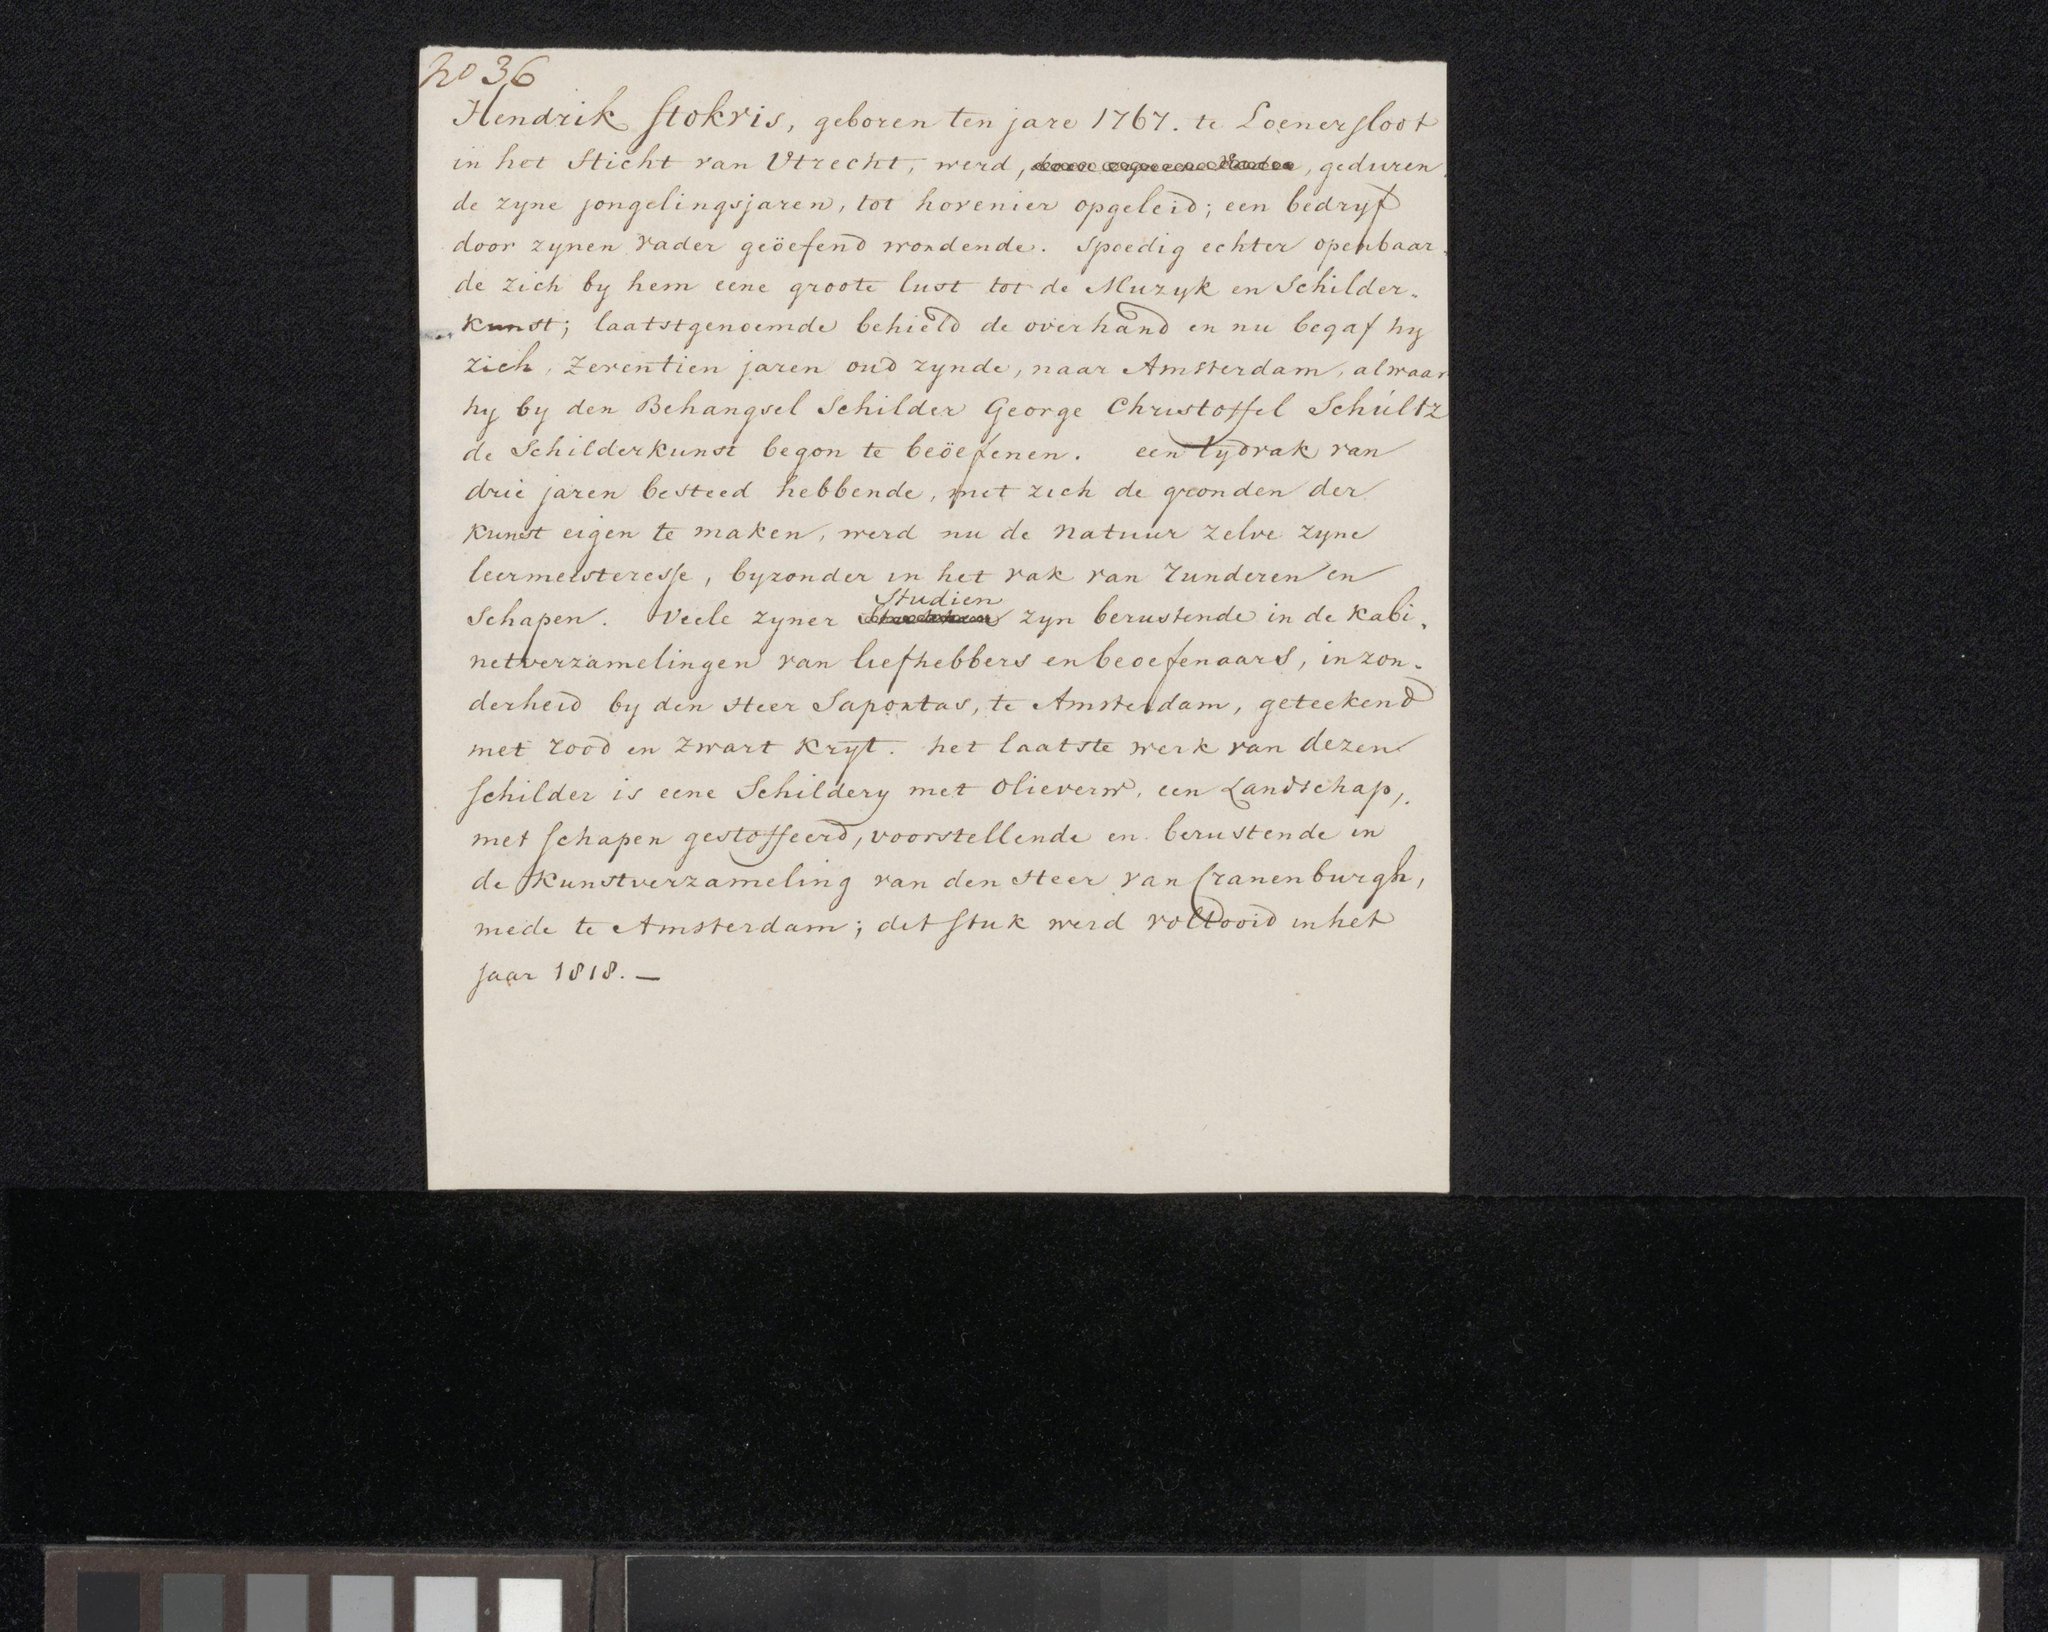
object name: manuscript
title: Handschrift betreffende Hendrik Stokvisch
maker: Anonymous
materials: ink, paper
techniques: pen, writing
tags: amsterdam, painter, draughtsman, hendrik stokvisch, music, painting (including book-illumination, miniature-painting)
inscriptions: watermark